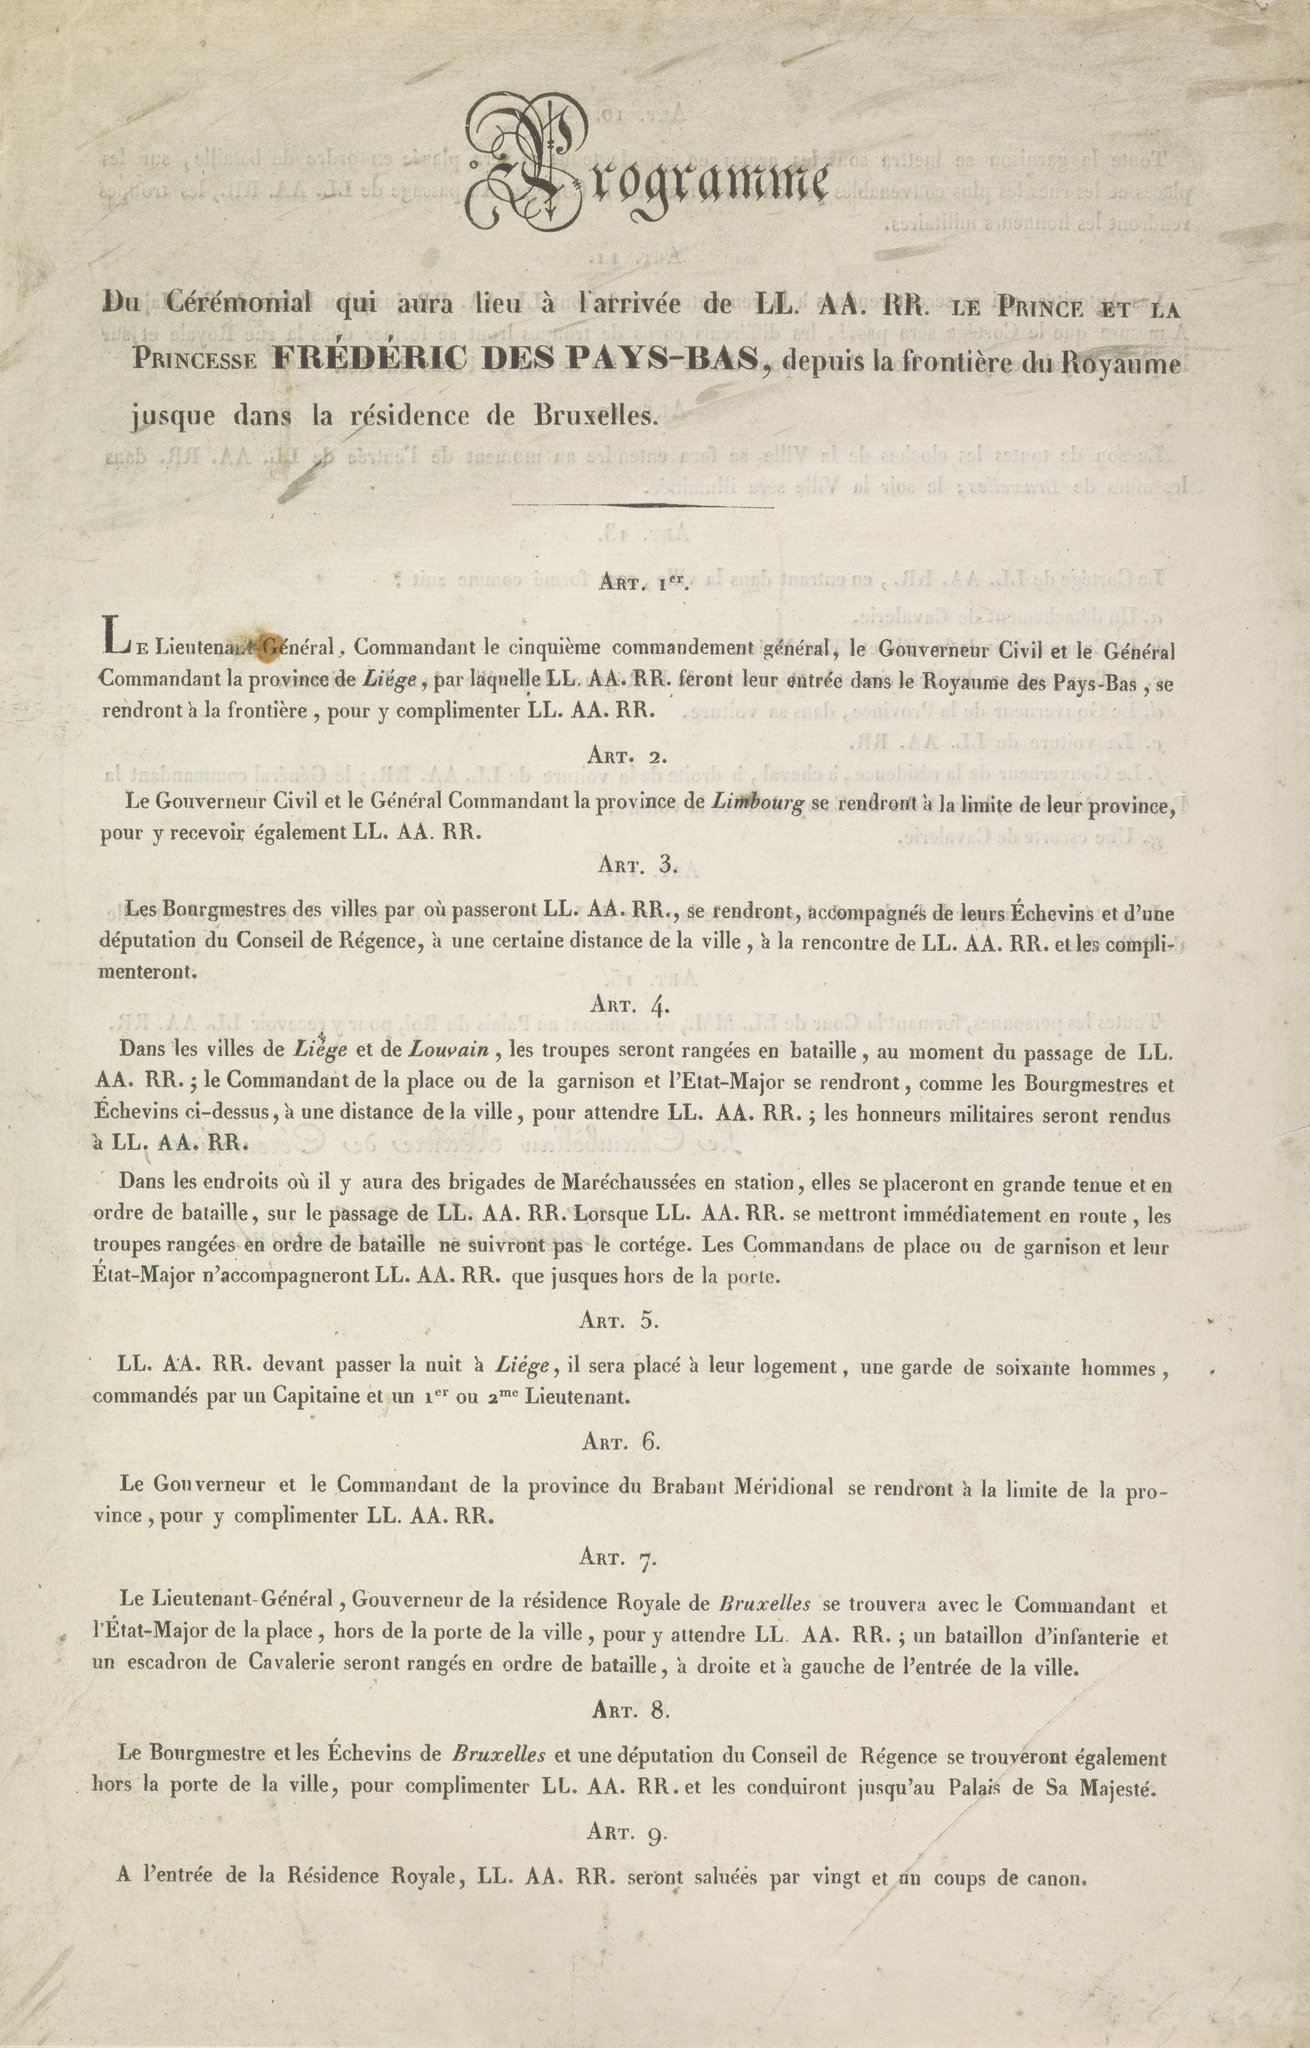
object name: programma, programmaboekje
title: Programma van de ontvangst van het prinselijk paar te Brussel, 1825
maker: Anonymous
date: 1825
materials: paper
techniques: letterpress printing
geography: brussels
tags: frederik (prins der nederlanden), brussels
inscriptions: collector's mark: Lugt 2228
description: Programma van de ceremoniële ontvangst van het echtpaar prins Frederik en prinses Louise van Pruisen, te Brussel na hun huwelijk op 21 mei 1825. Blad bedrukt op beide zijden met een lijst van 15 genummerde artikelen, opgesteld door de kamermeester Comte D'Outremont.